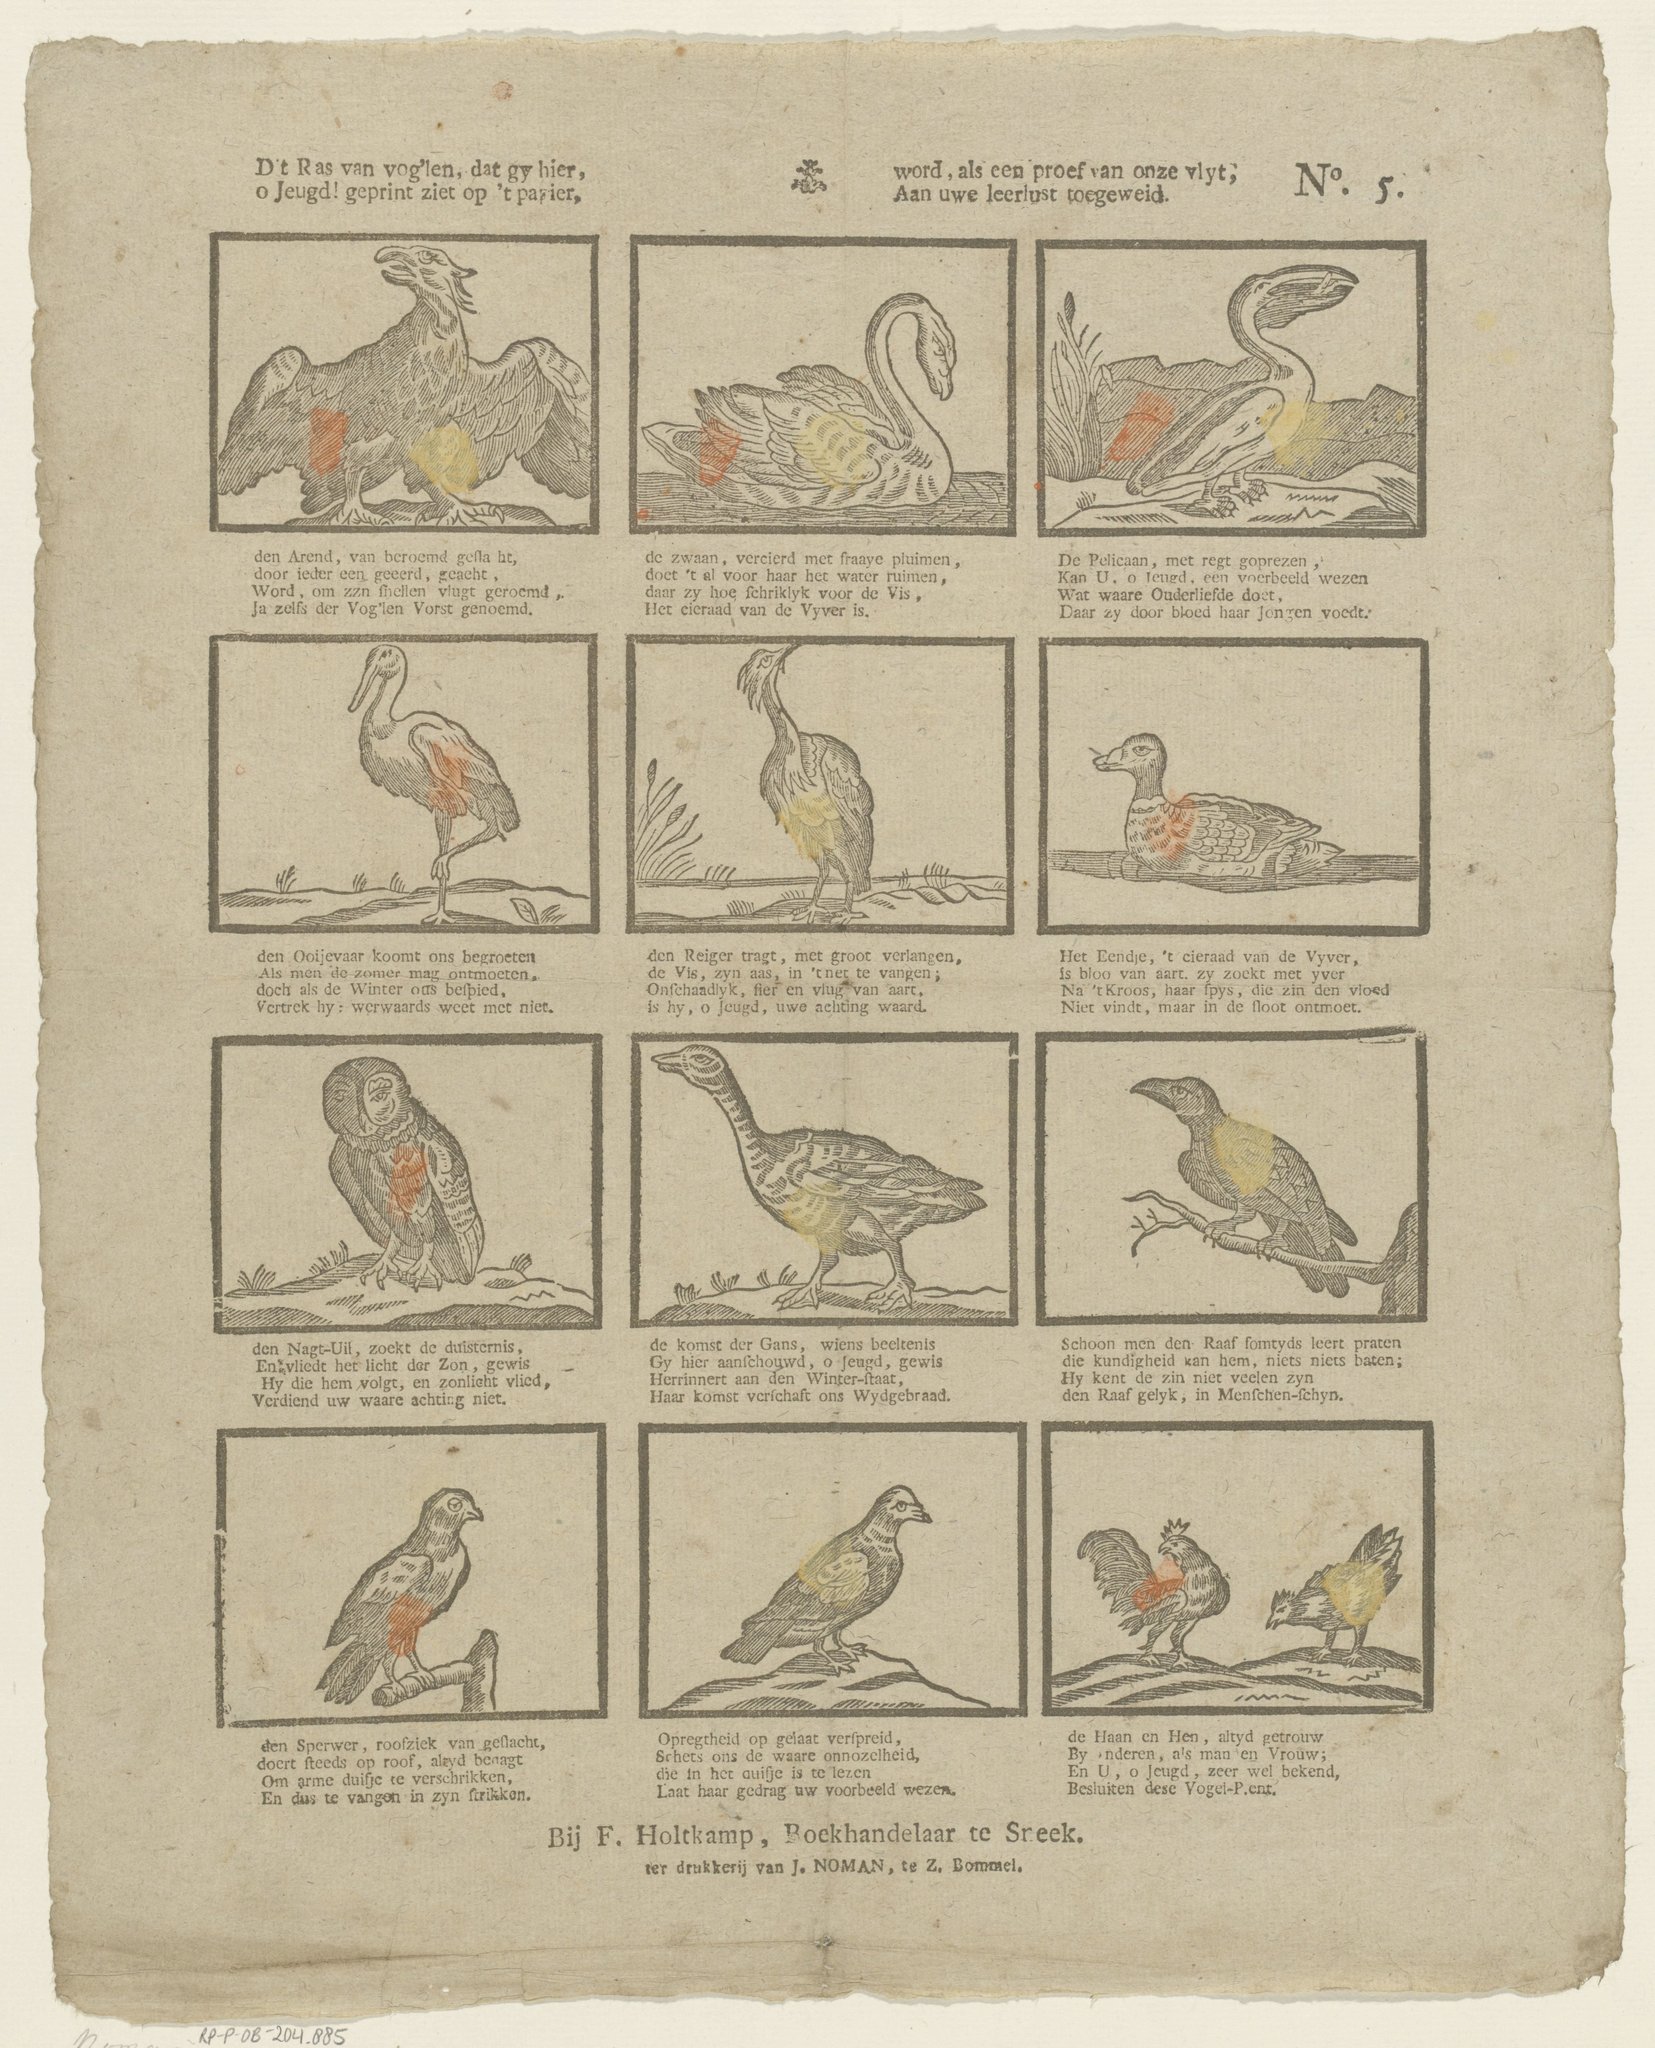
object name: print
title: Dit ras van vog'len, dat gij hier, / o jeugd! geprint ziet op 't papier, / Word, als een proef van onze vlijt / Aan uwe leerlust toegeweid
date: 1806-1830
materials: paper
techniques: colour, letterpress printing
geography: netherlands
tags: birds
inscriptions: collector's mark: Lugt 2760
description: Blad met 12 voorstellingen van vogels, zoals een arend, een zwaan en een pelikaan. Onder elke afbeelding een vierregelig vers. Genummerd rechtsboven: No. 5.